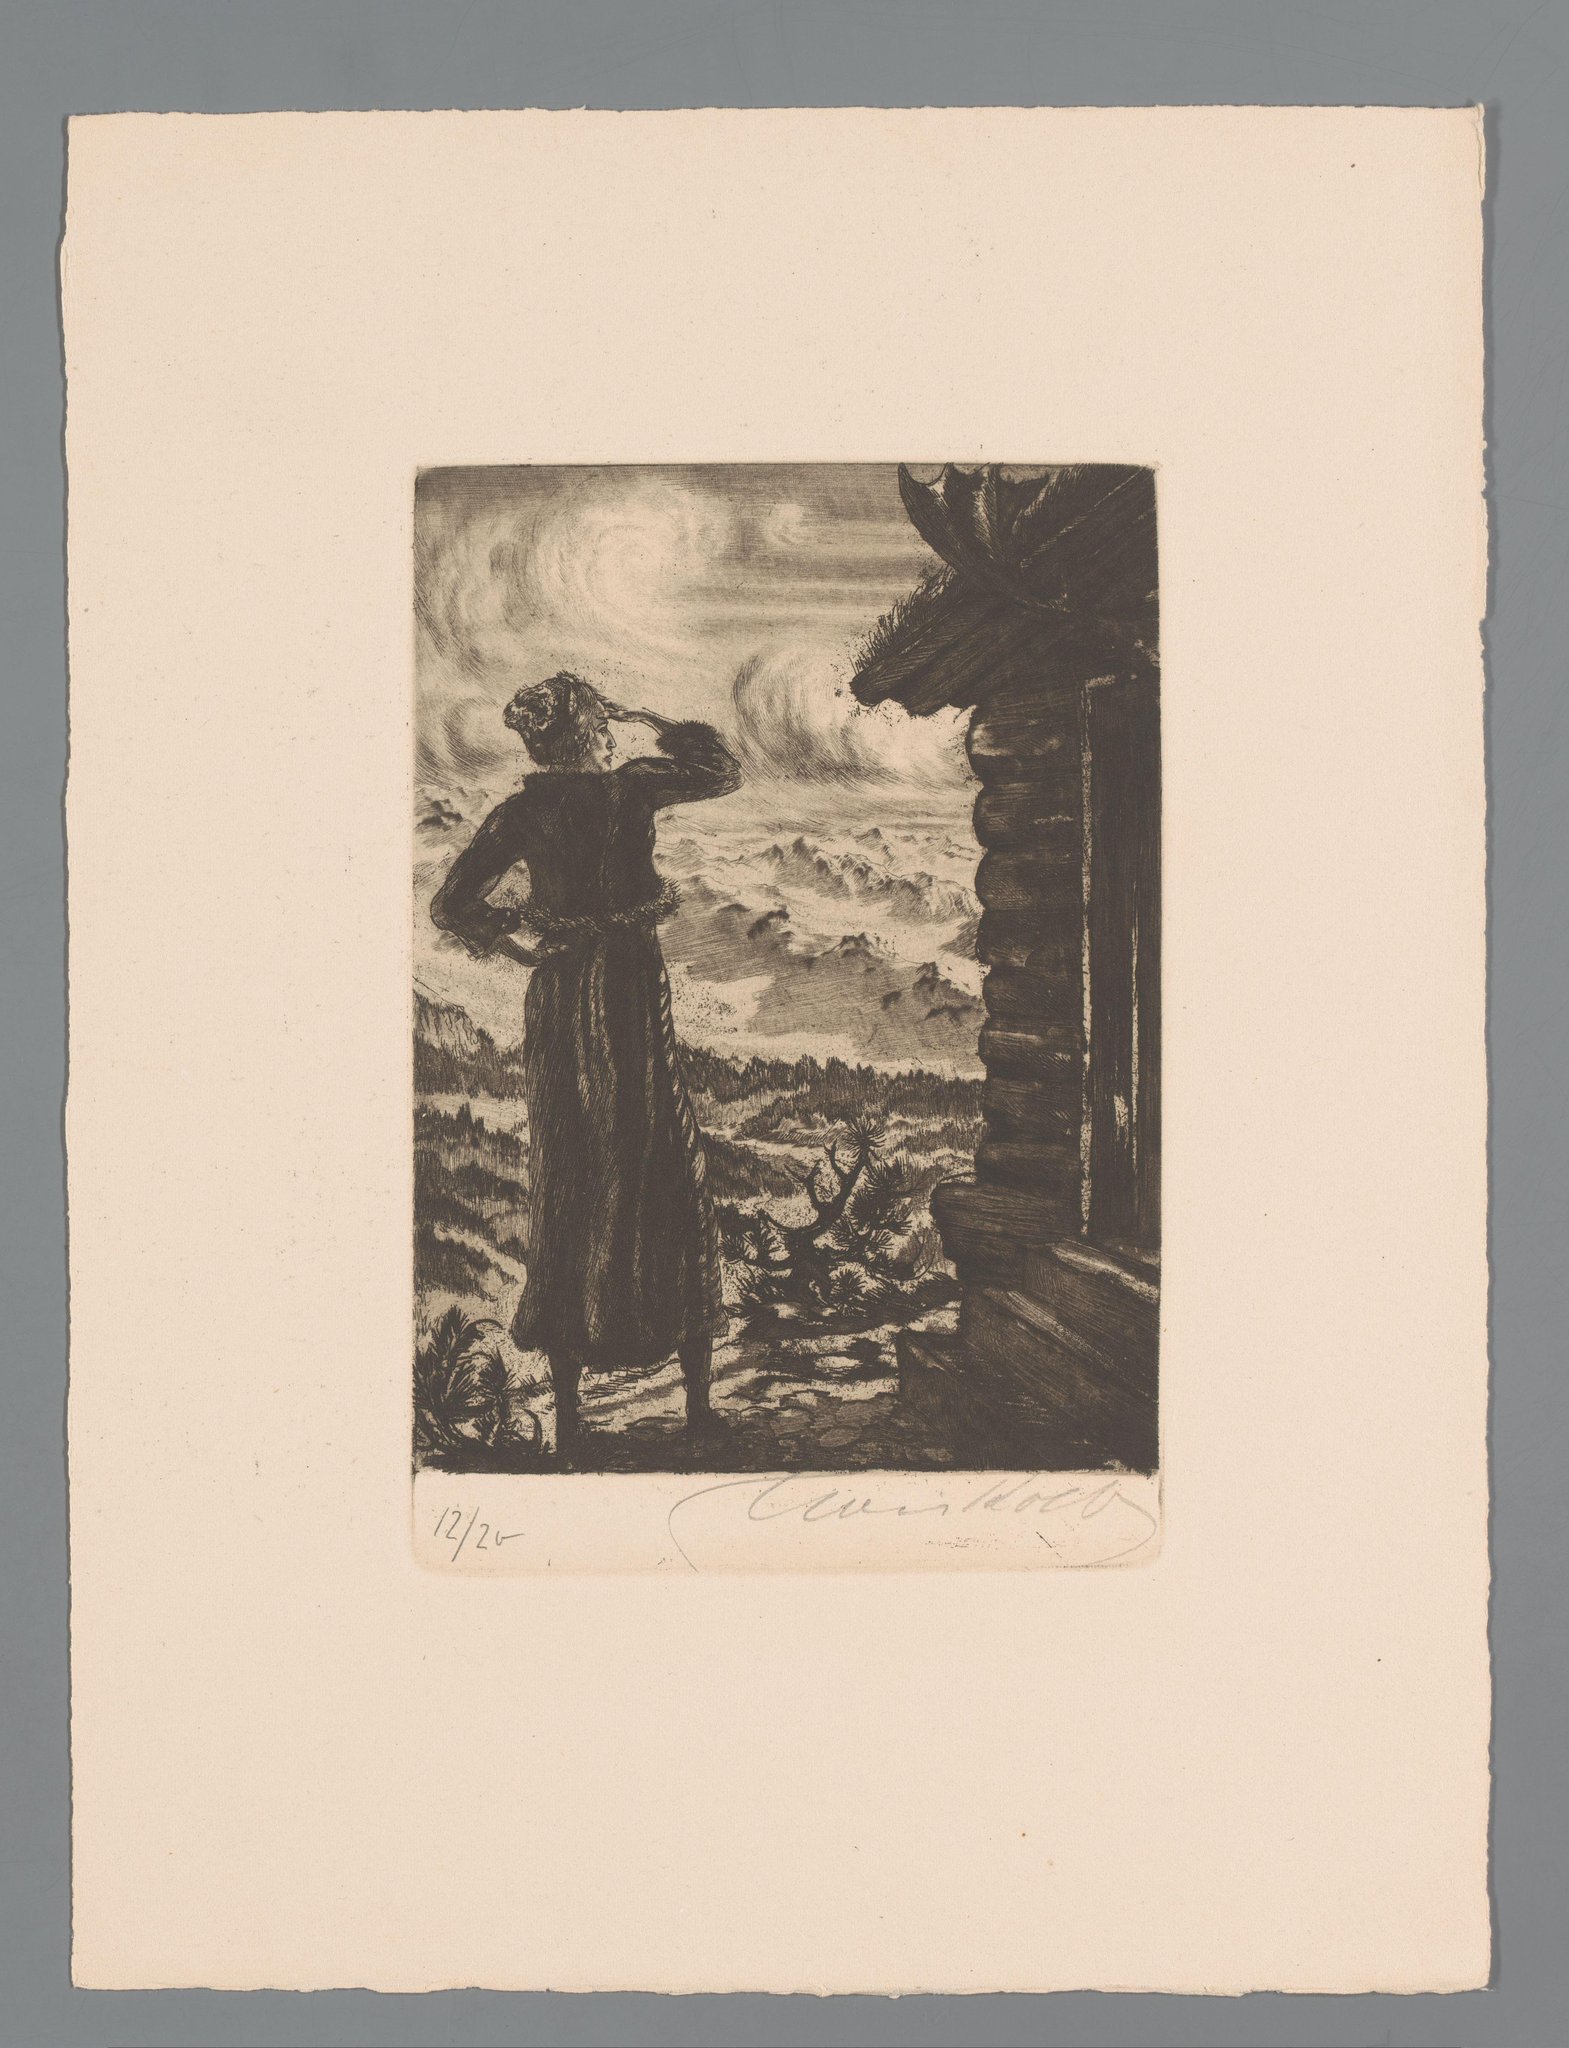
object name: print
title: Vrouw bij een blokhut turend over het berglandschap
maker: alois kolb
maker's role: print maker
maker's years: 1875-1942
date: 1885-1924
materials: paper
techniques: drypoint, etching, intaglio, soft ground etching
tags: log-cabin, looking with the hand above the eyes, mountains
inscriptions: collector's mark: Lugt 2228